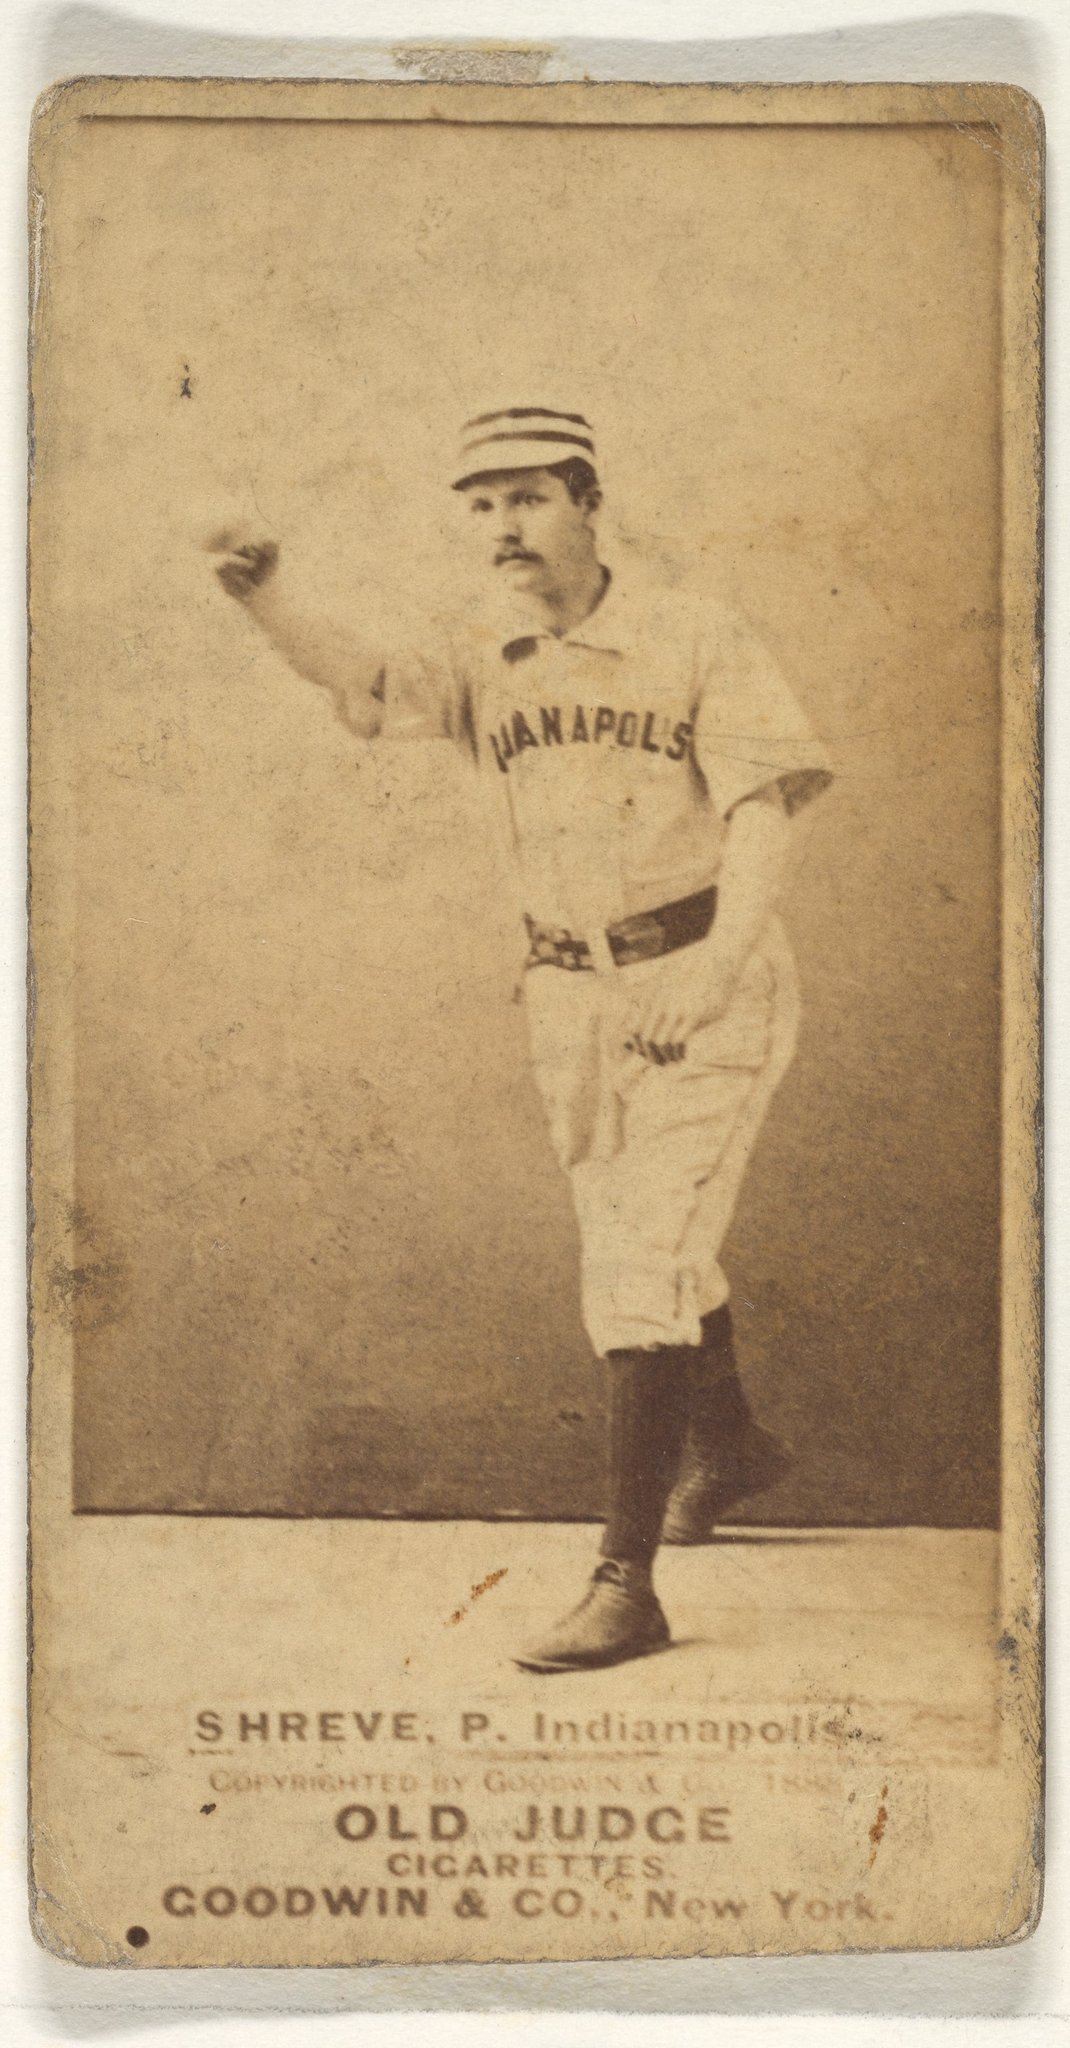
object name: baseball card, photograph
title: Lev Shreve, Pitcher, Indianapolis, from the Old Judge series (N172) for Old Judge Cigarettes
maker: goodwin & company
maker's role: publisher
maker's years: 1850-1950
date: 1887-1890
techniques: albumen silver print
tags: men,portraits,baseball,athletes